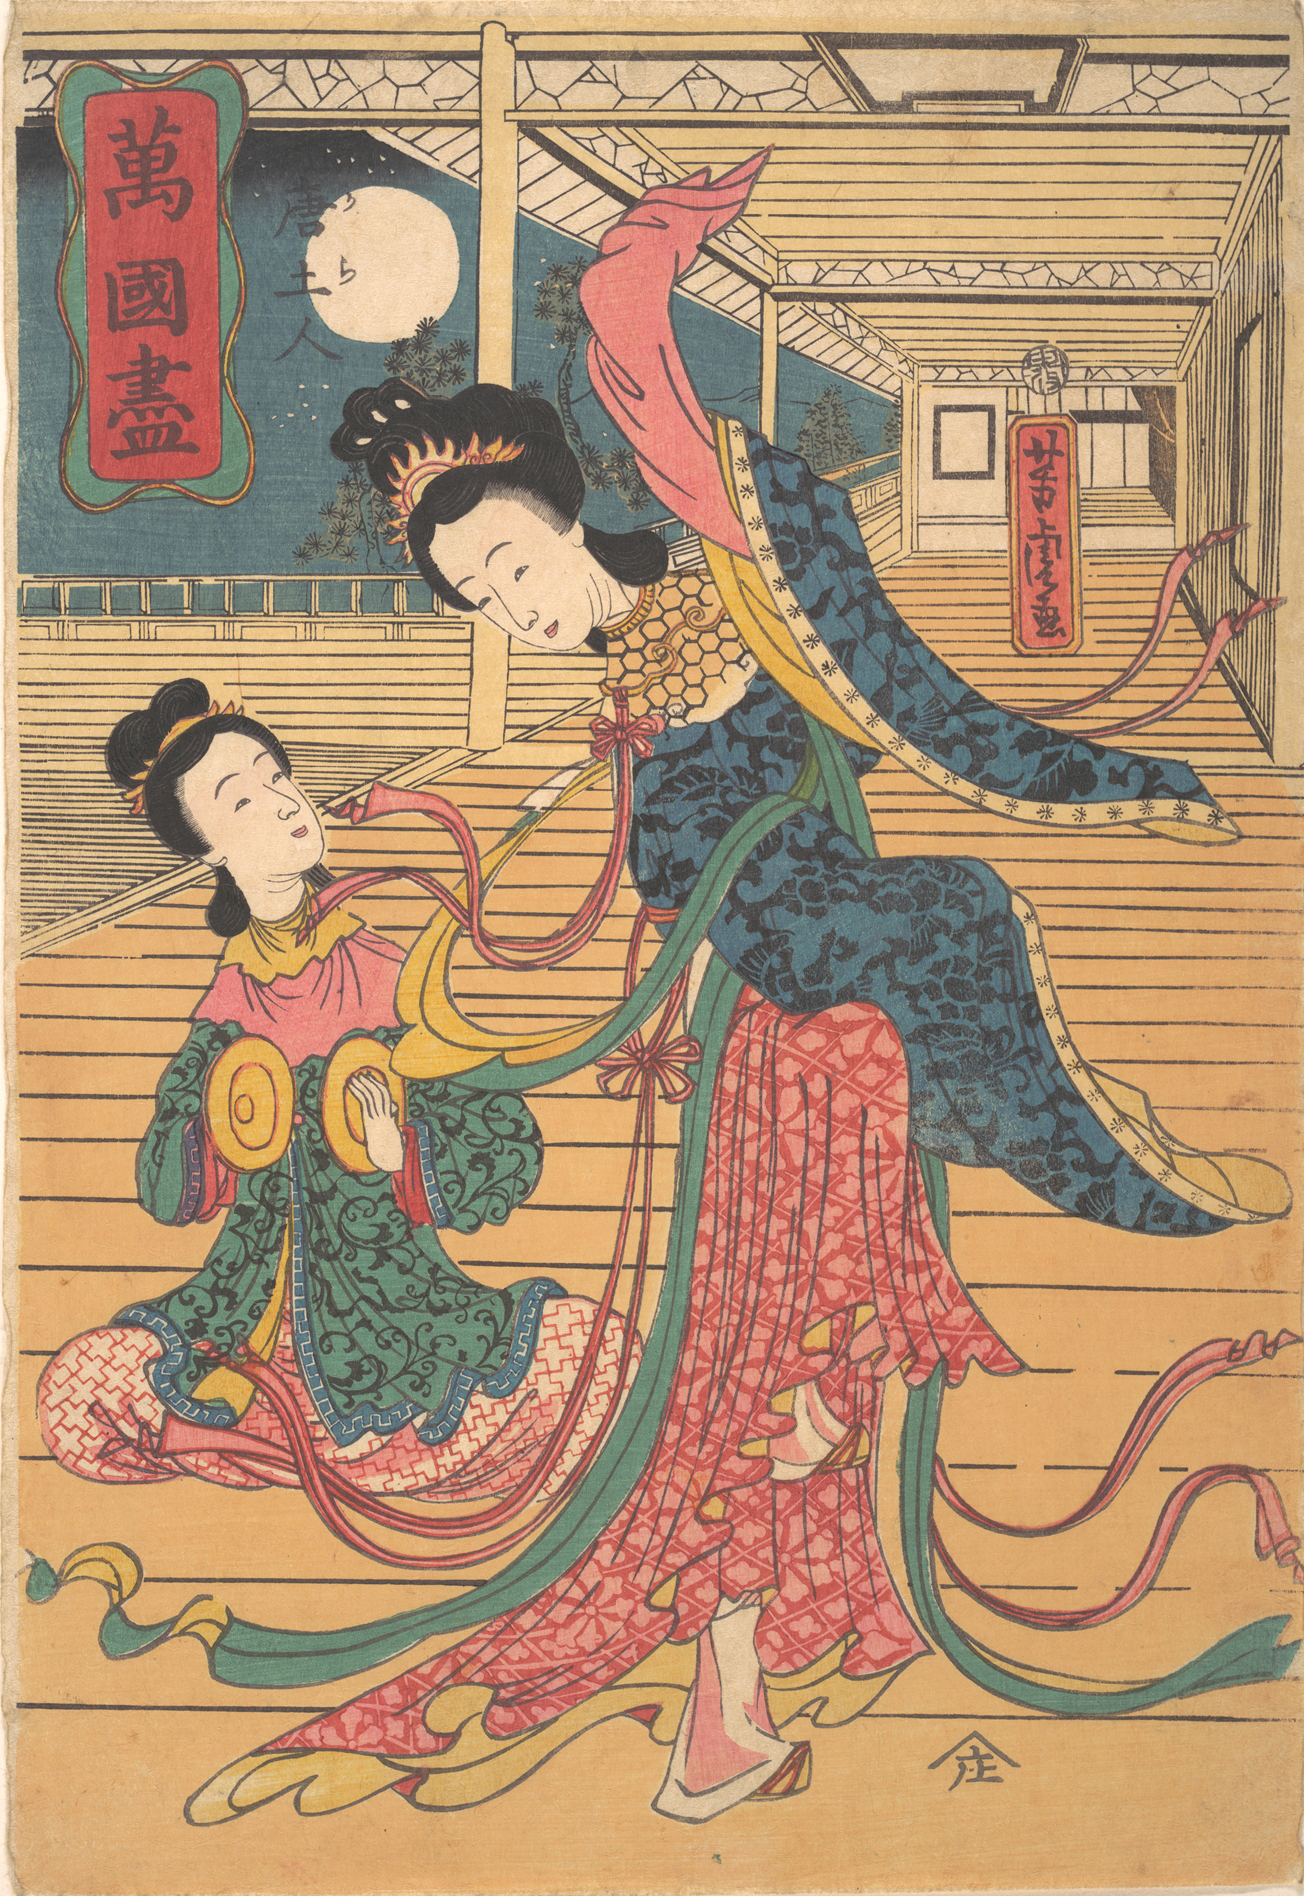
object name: print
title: Two Chinese Women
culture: japanese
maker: utagawa yoshitora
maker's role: artist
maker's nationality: japanese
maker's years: 1845-1880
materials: ink, paper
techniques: woodblock print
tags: women